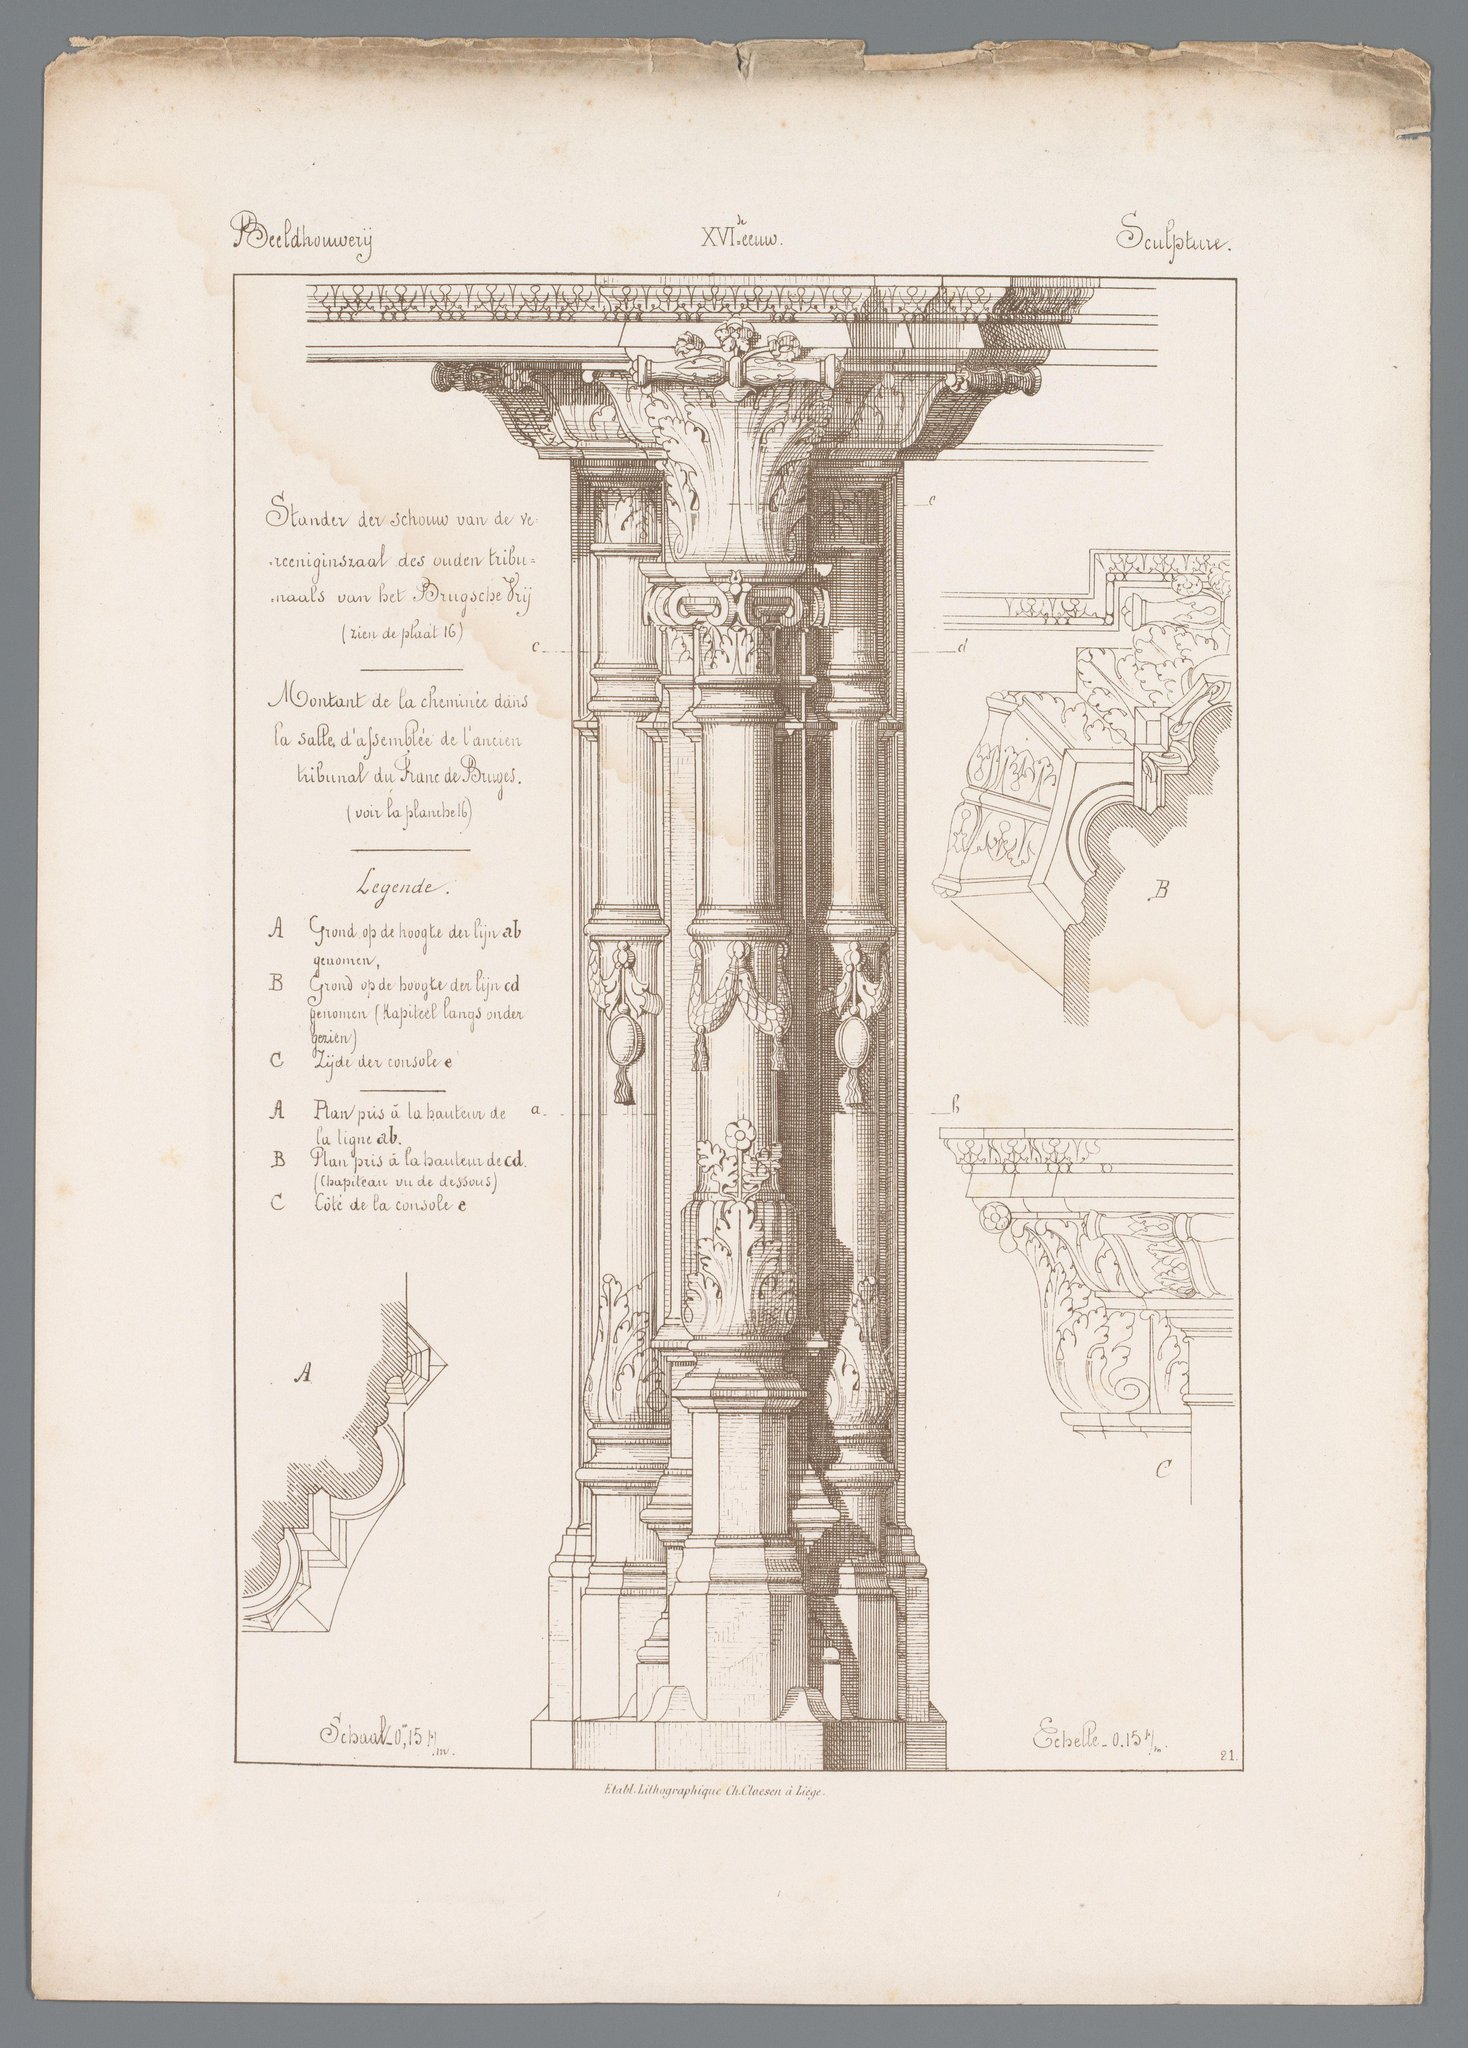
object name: print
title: Zuil in Brugse Vrije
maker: Anonymous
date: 1800-1899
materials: paper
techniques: lithograph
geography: liège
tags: column, pillar ~ architecture, bruges